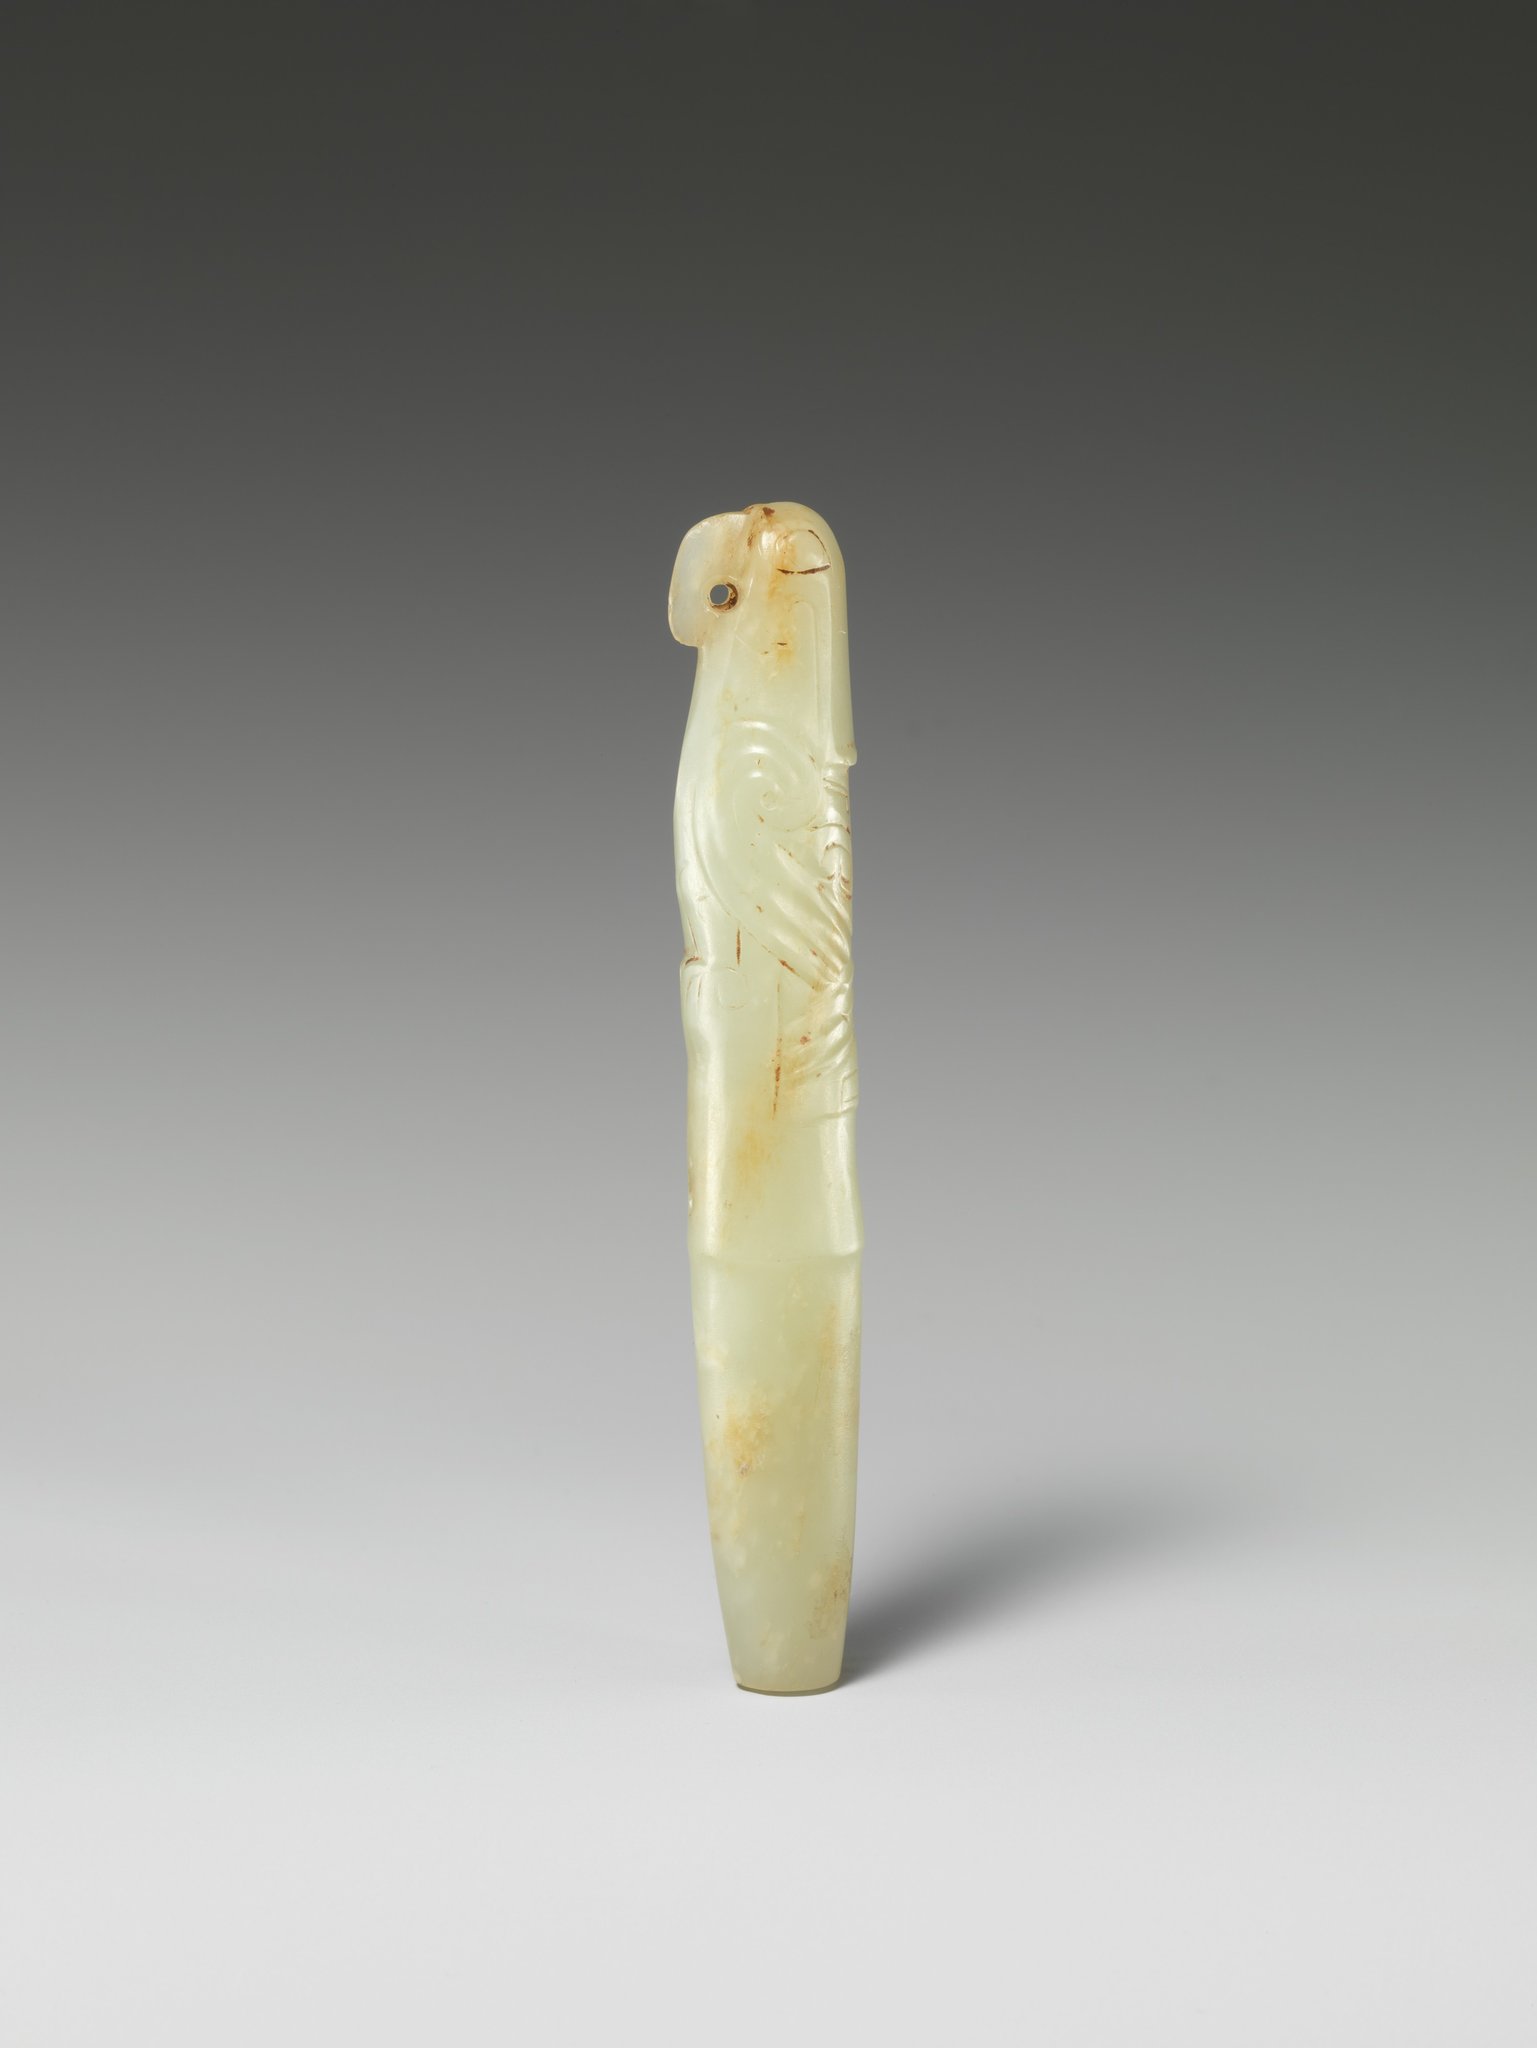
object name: pendant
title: Pendant in the shape of a bird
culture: chinese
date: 2000-1500 BCE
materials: jade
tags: birds